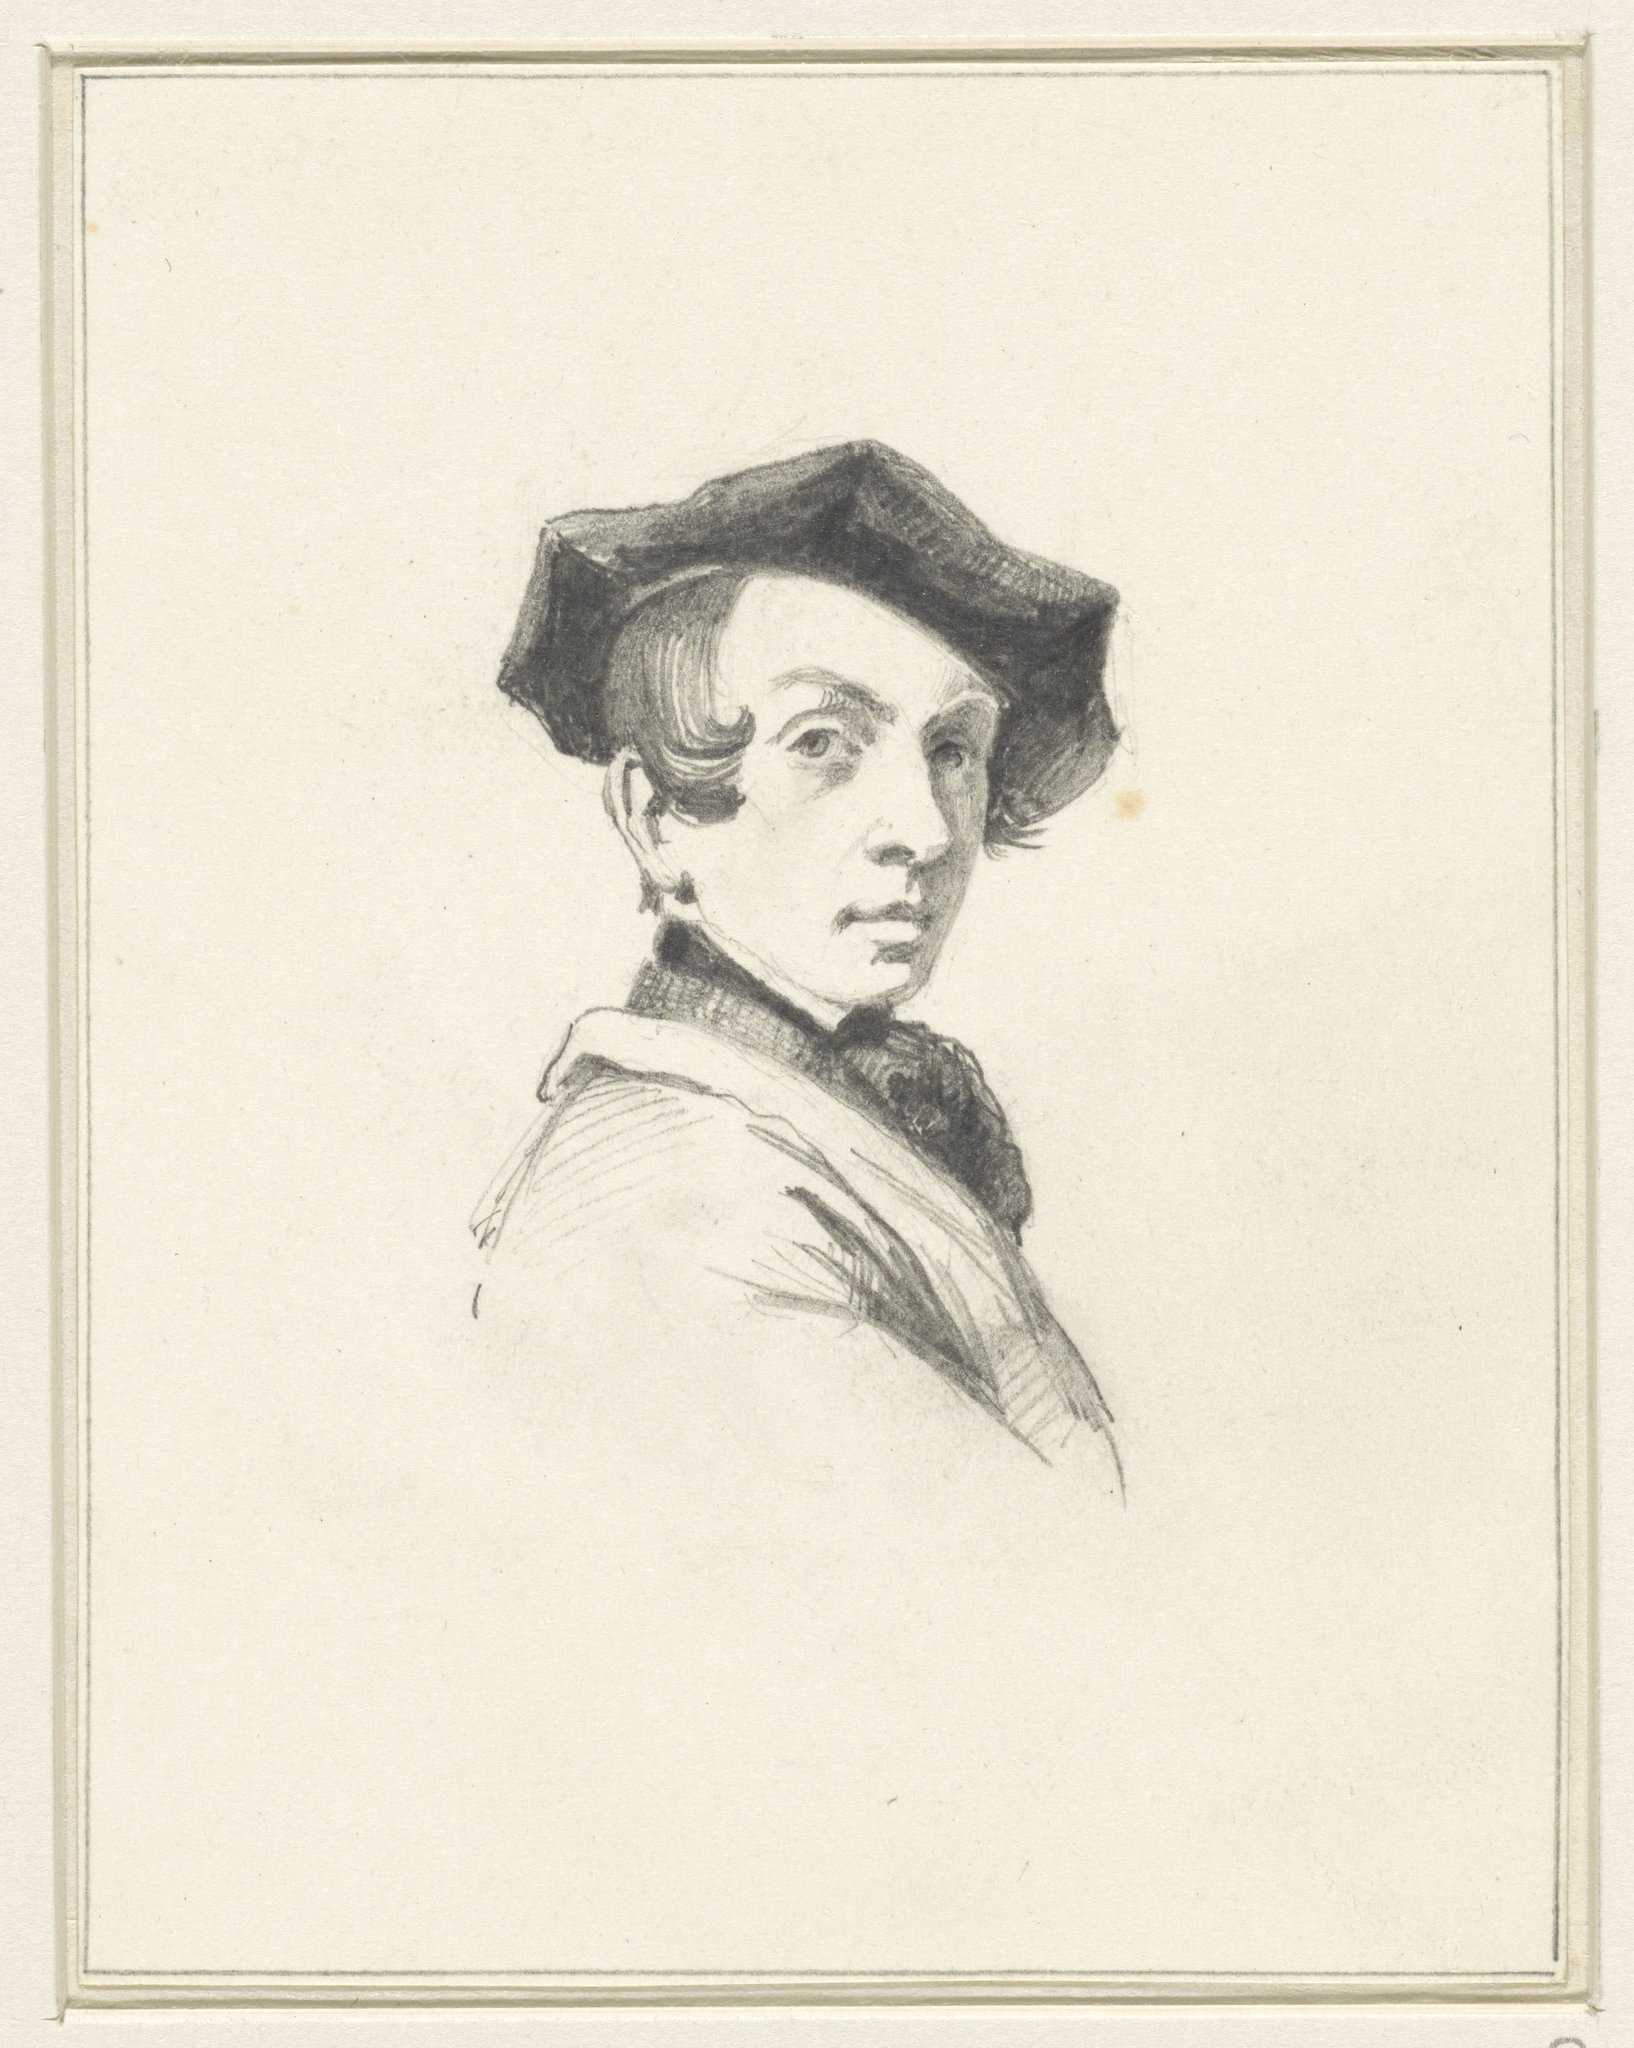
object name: drawing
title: Zelfportret van Jan Wendel Gerstenhauer Zimmerman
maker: jan wendel gerstenhauer zimmerman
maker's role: draughtsman, print maker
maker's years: 1816-1887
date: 1826-1887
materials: paper, pencil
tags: rotterdam, print maker, draughtsman, jan wendel gerstenhauer zimmerman, historical persons, portrait, self-portrait of artist, portrait, self-portrait of draughtsman